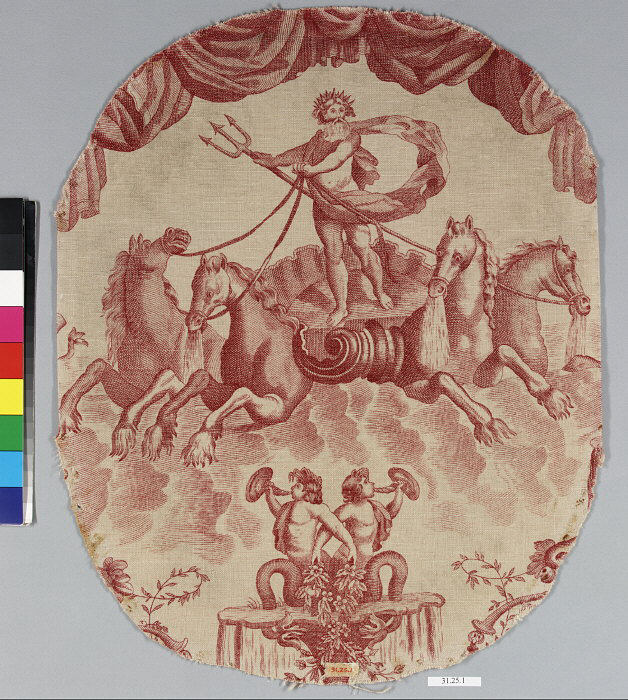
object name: fragment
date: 1701-1800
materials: linen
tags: men,horses